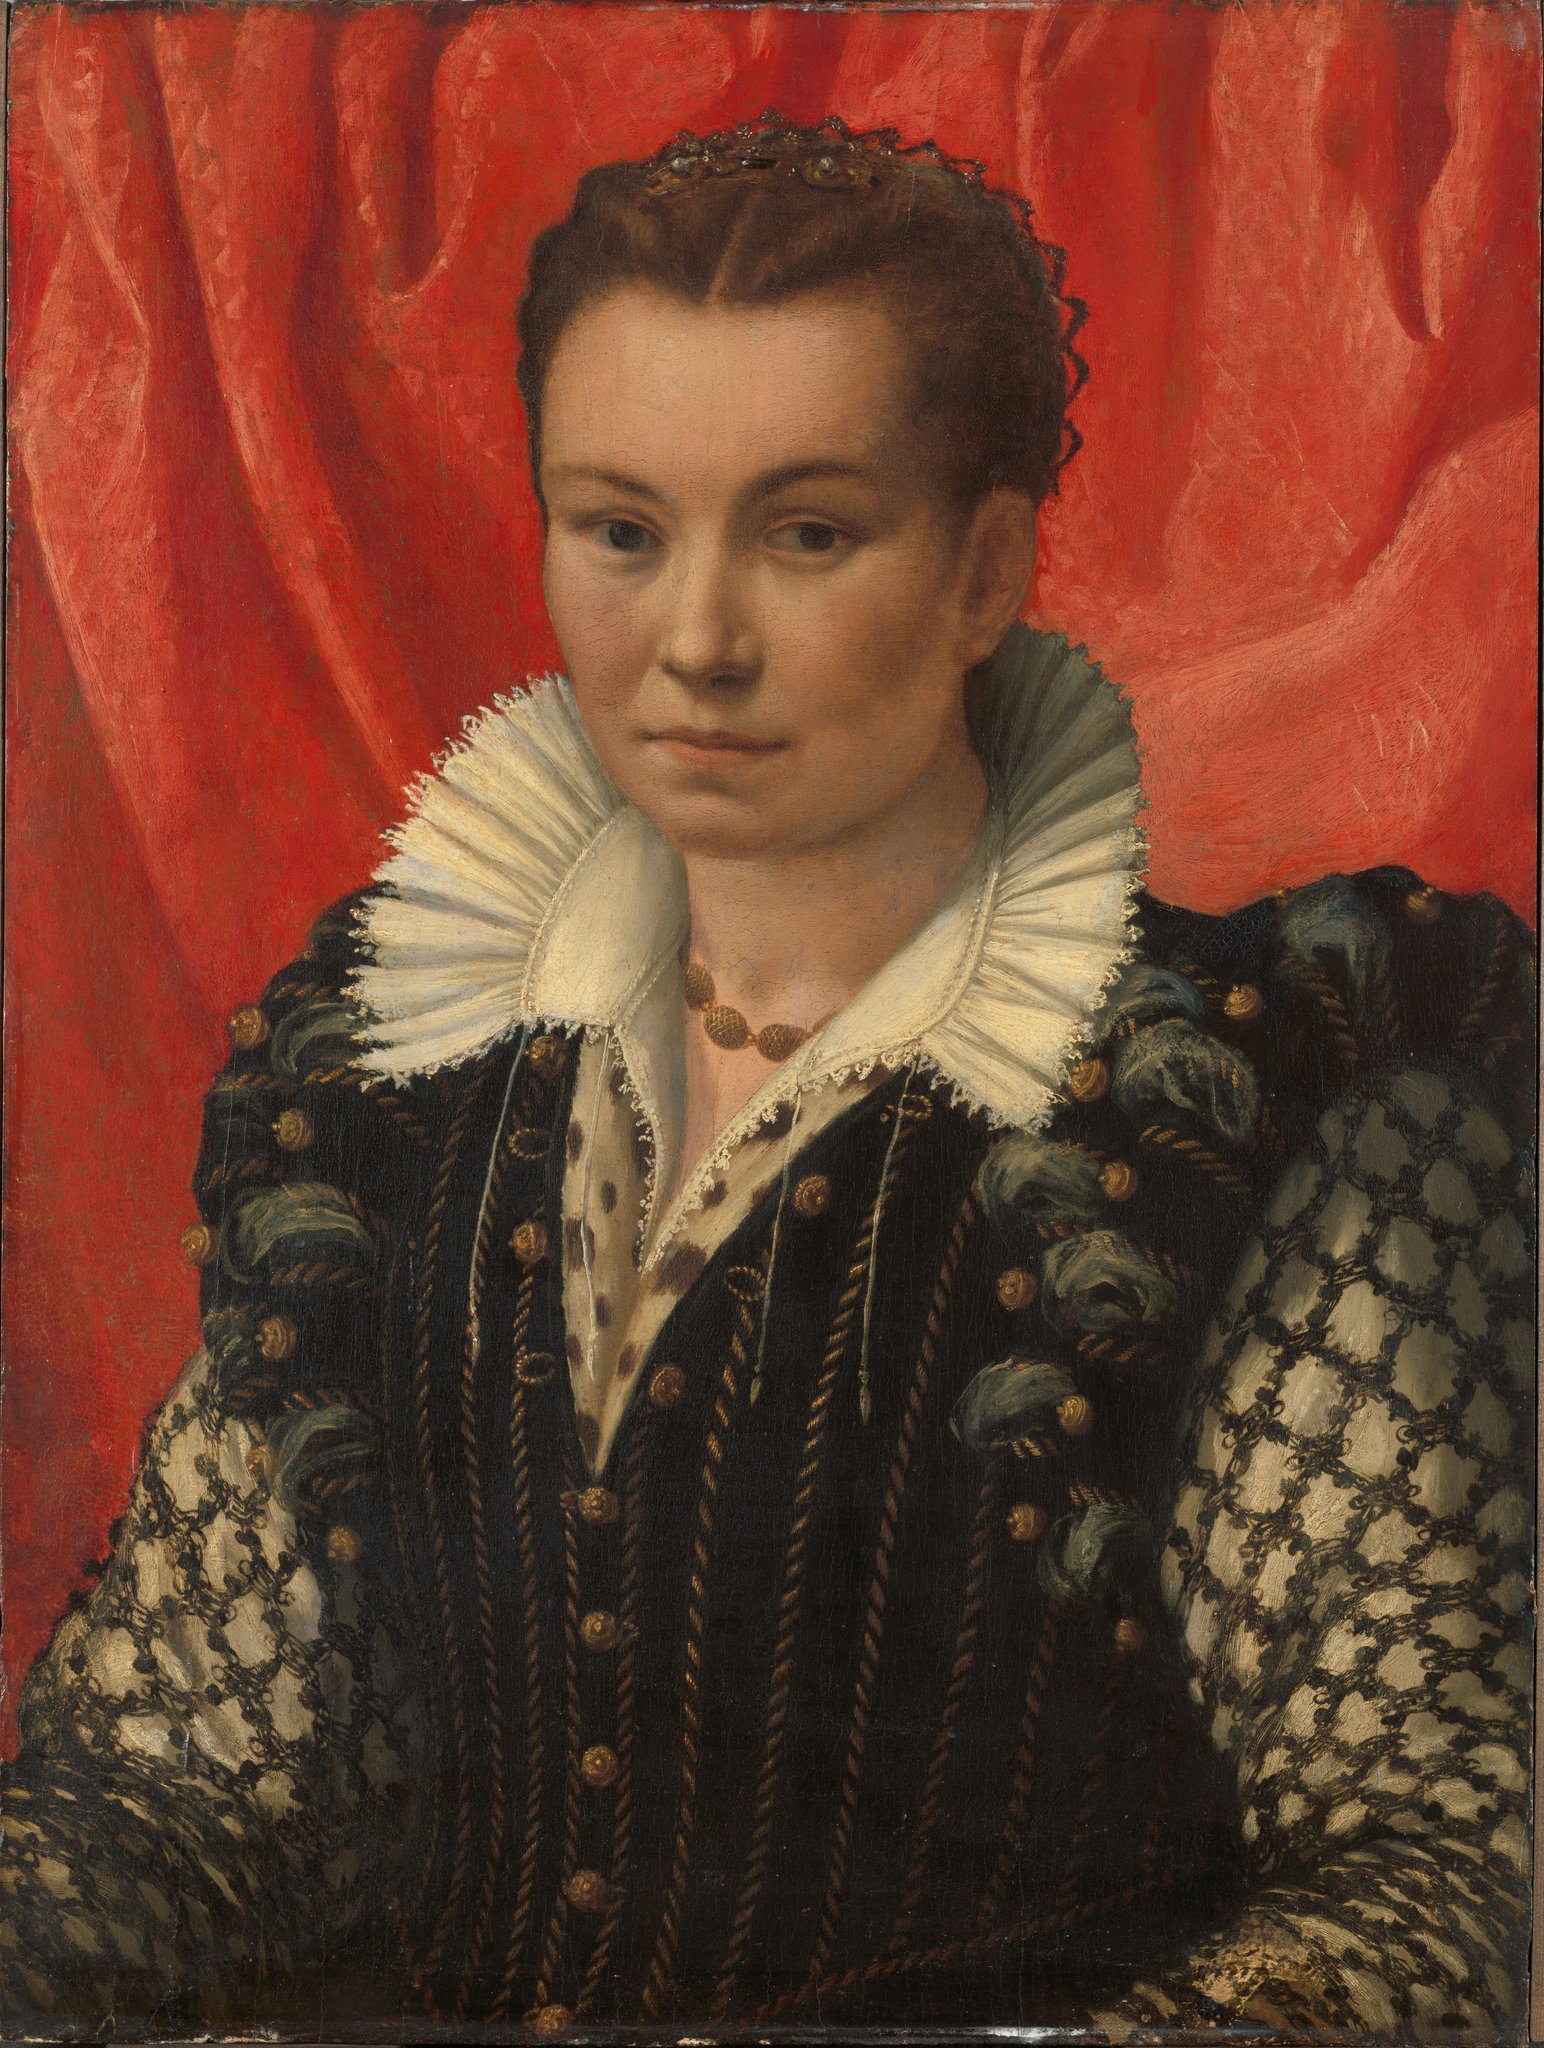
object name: painting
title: Portrait of a Woman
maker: Anonymous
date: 1525-1549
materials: oil, panel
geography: milan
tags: anonymous historical person portrayed - bb - woman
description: Portret van een vrouw met donker haar, ten halven lijve, in een zwart fluwelen kleed, iets naar links.